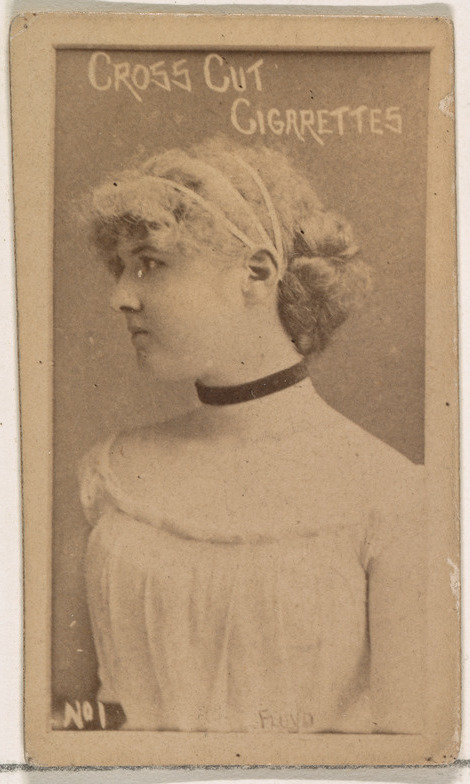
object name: print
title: Card Number 1, Floyd, from the Actors and Actresses series (N145-1) issued by Duke Sons & Co. to promote Cross Cut Cigarettes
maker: w. duke, sons & co.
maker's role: publisher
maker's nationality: american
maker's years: 1870-1920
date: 1880-1889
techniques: albumen silver print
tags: portraits,women,actresses